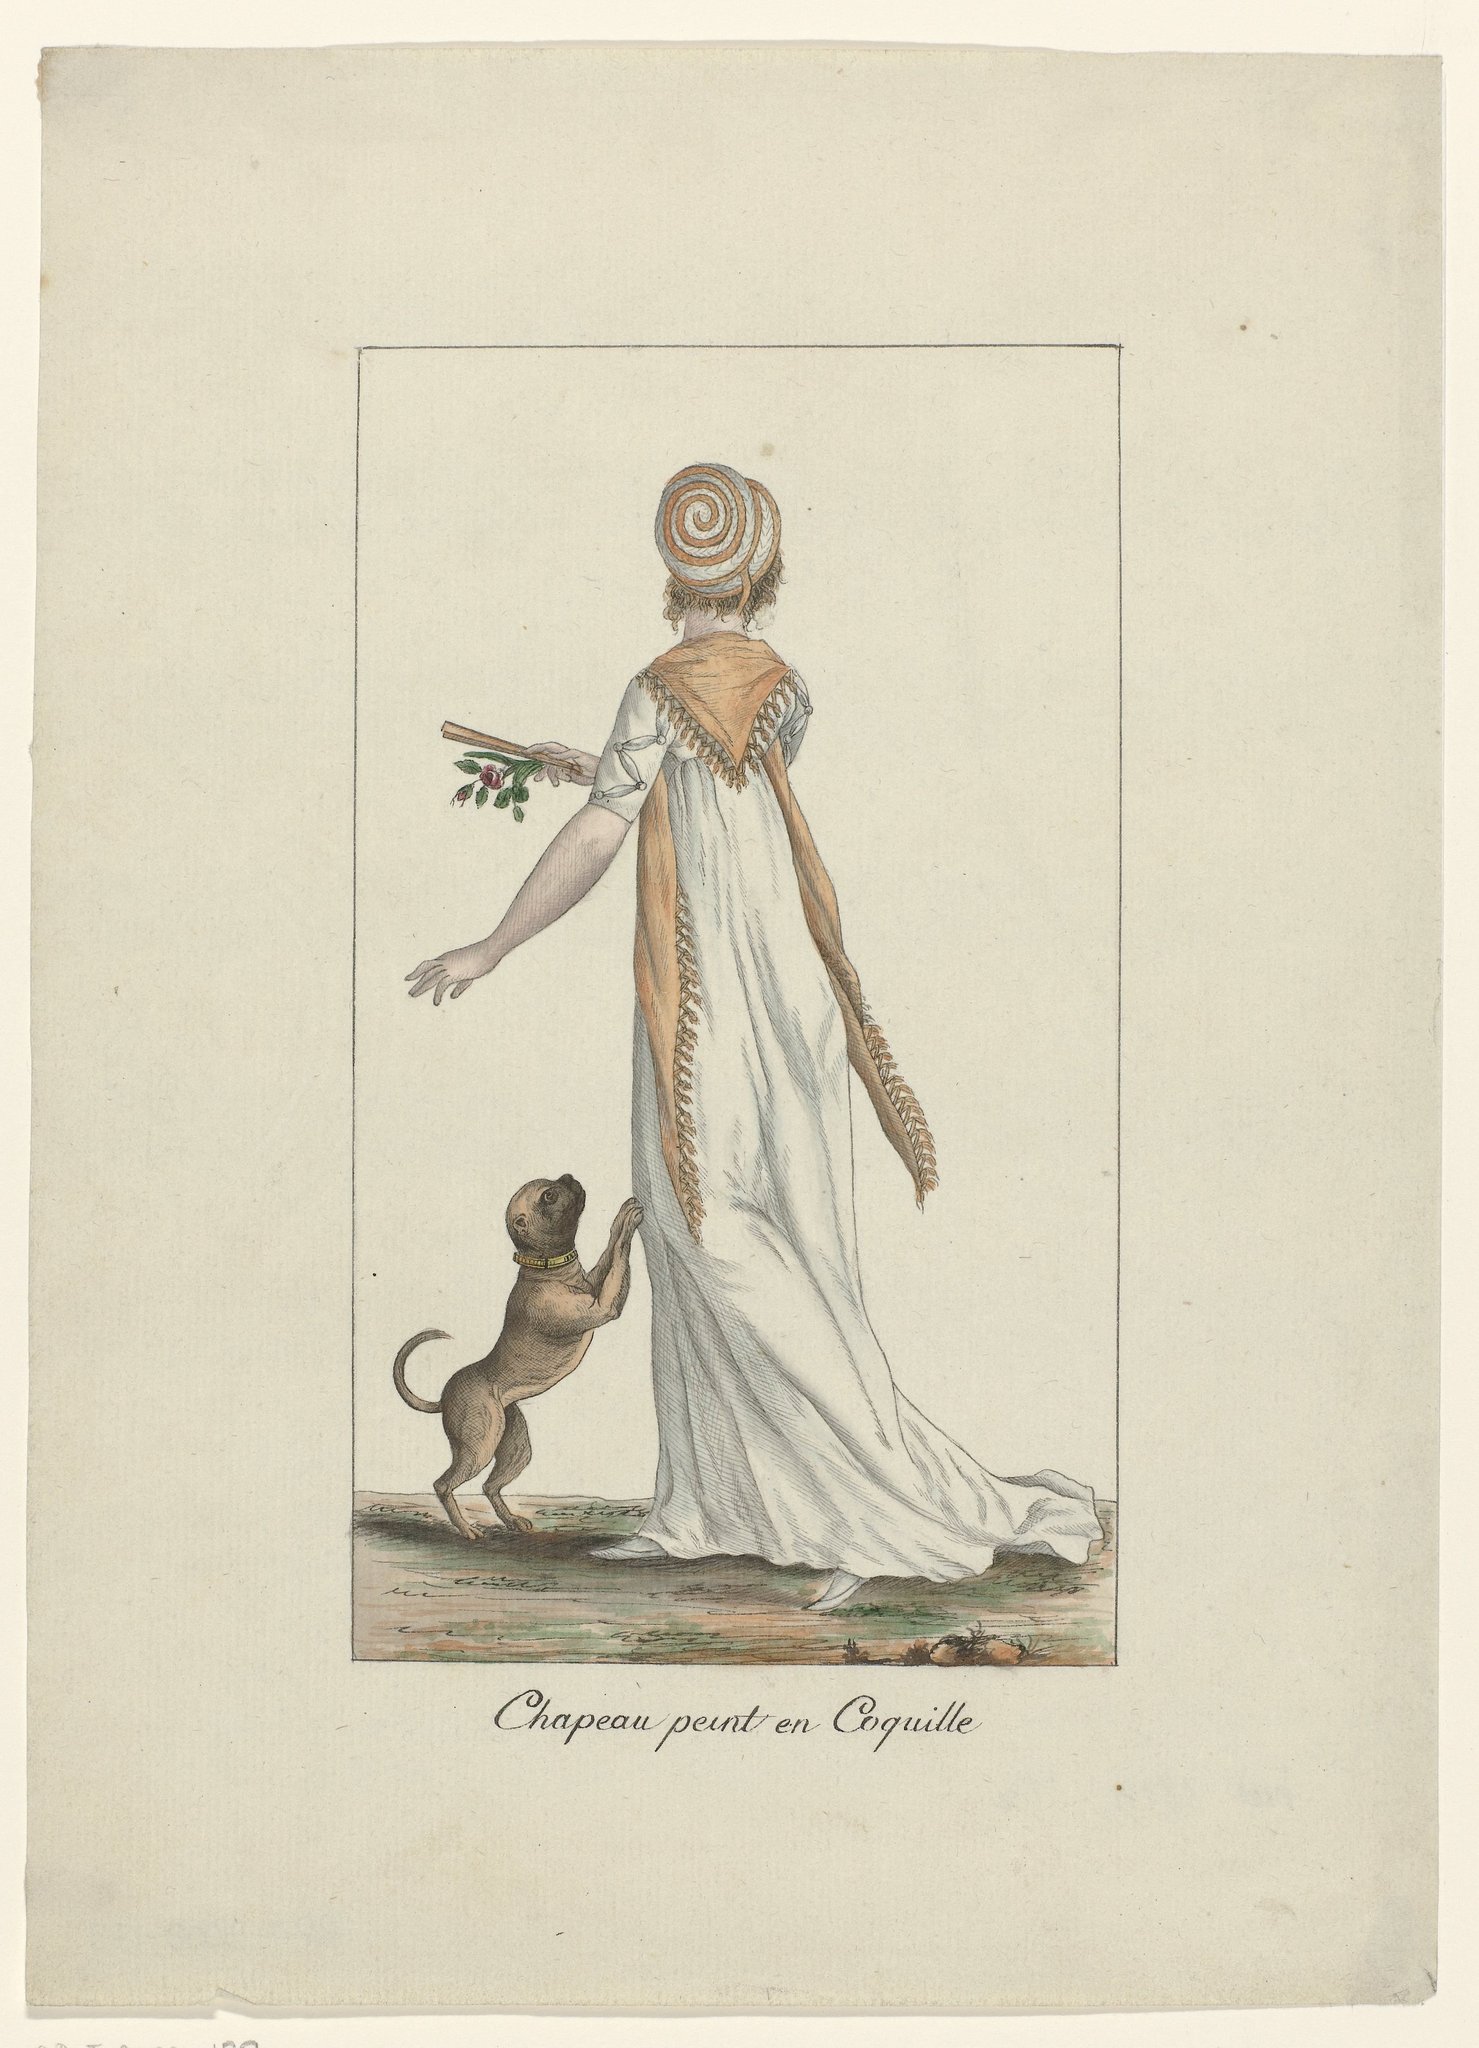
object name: drawing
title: Journal des Dames et des Modes, Costume Parisien, 10 mai 1800, An 8, (215) : Chapeau peint en Coquille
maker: Anonymous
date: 1800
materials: ink, paper, watercolor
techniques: brush, pen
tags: cut flowers; nosegay, bunch of flowers, clothing for the upper part of the body (shawl) (+ women's clothes), fashion plates, head-gear: hat (+ women's clothes), shoes, sandals (+ women's clothes), dress, gown (+ women's clothes), fan (+ women's clothes), collar (of a dog)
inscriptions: caption: ‘Chapeau peint en Coquille’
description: Vrouw, op de rug gezien, lopend naar links, met op het hoofd een beschilderde hoed: 'Chapeau peint en Coquille'. Zij draagt een japon met korte mouwen en sleep. Op de achterzijde van de mouw een zig-zag versiering. Verdere accessoires: om de schouders een sjaal afgezet met franjes, waaier, lage schoenen met puntige neuzen. In de rechterhand een bloem. Links een opspringend hondje met halsband. Voortekening voor prent 215 in Journal des Dames et des Modes, Costume Parisien, 10 mai 1800, An 8, uitgegeven door Pierre de la Mésangère, Parijs, 1797-1839.